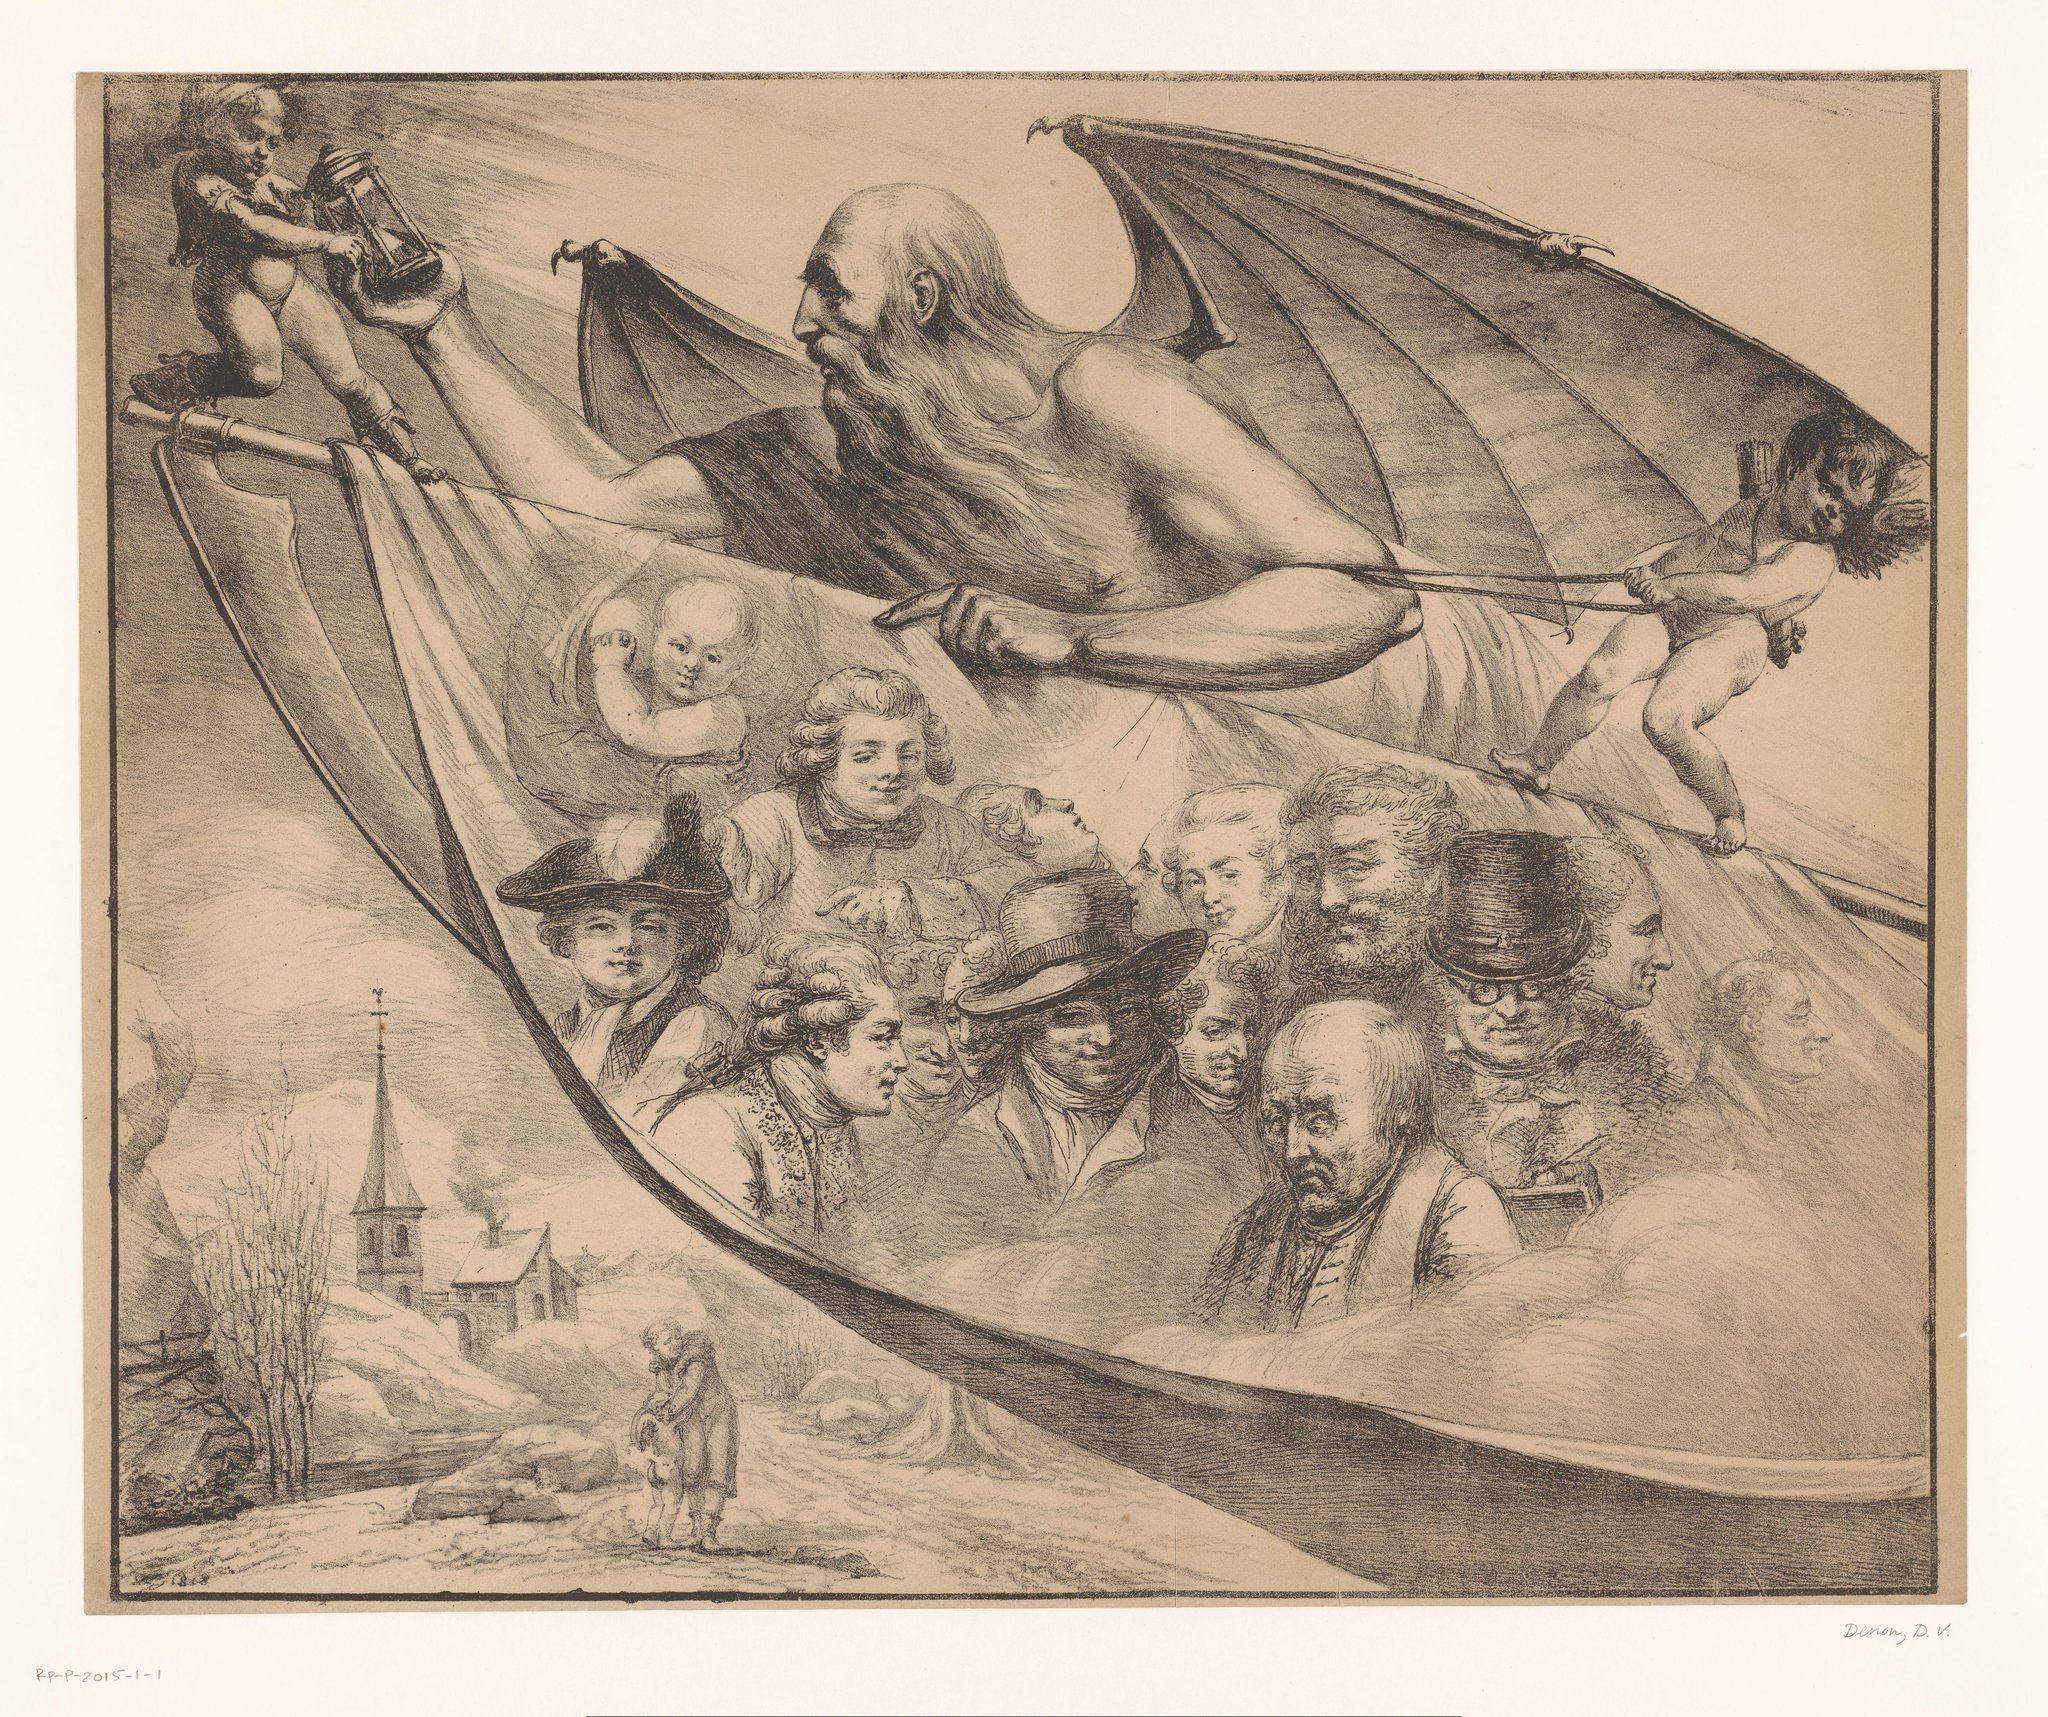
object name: print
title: Vader Tijd toont herinneringen aan Vivant Denon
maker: dominique vivant denon (baron)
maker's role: draughtsman, print maker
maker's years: 1747-1825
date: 1818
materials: paper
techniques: lithograph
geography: paris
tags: print maker, draughtsman, dominique vivant denon (baron), 'vanitas' symbols, memory; 'memoria' (ripa), hourglass, father time, man with wings and scythe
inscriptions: collector's mark: Lugt 2760, collector's mark: Lugt 2228a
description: Vader Tijd met een banier aan zijn zeis, waarop zelfportretten van verschillende leeftijden staan van Dominique Vivant Denon. Staand op de zeis proberen twee putti de voortgang van Vader Tijd tegen te houden. Links onderin een landschap met een kerkje en een figuur die een engeltje omhelst.